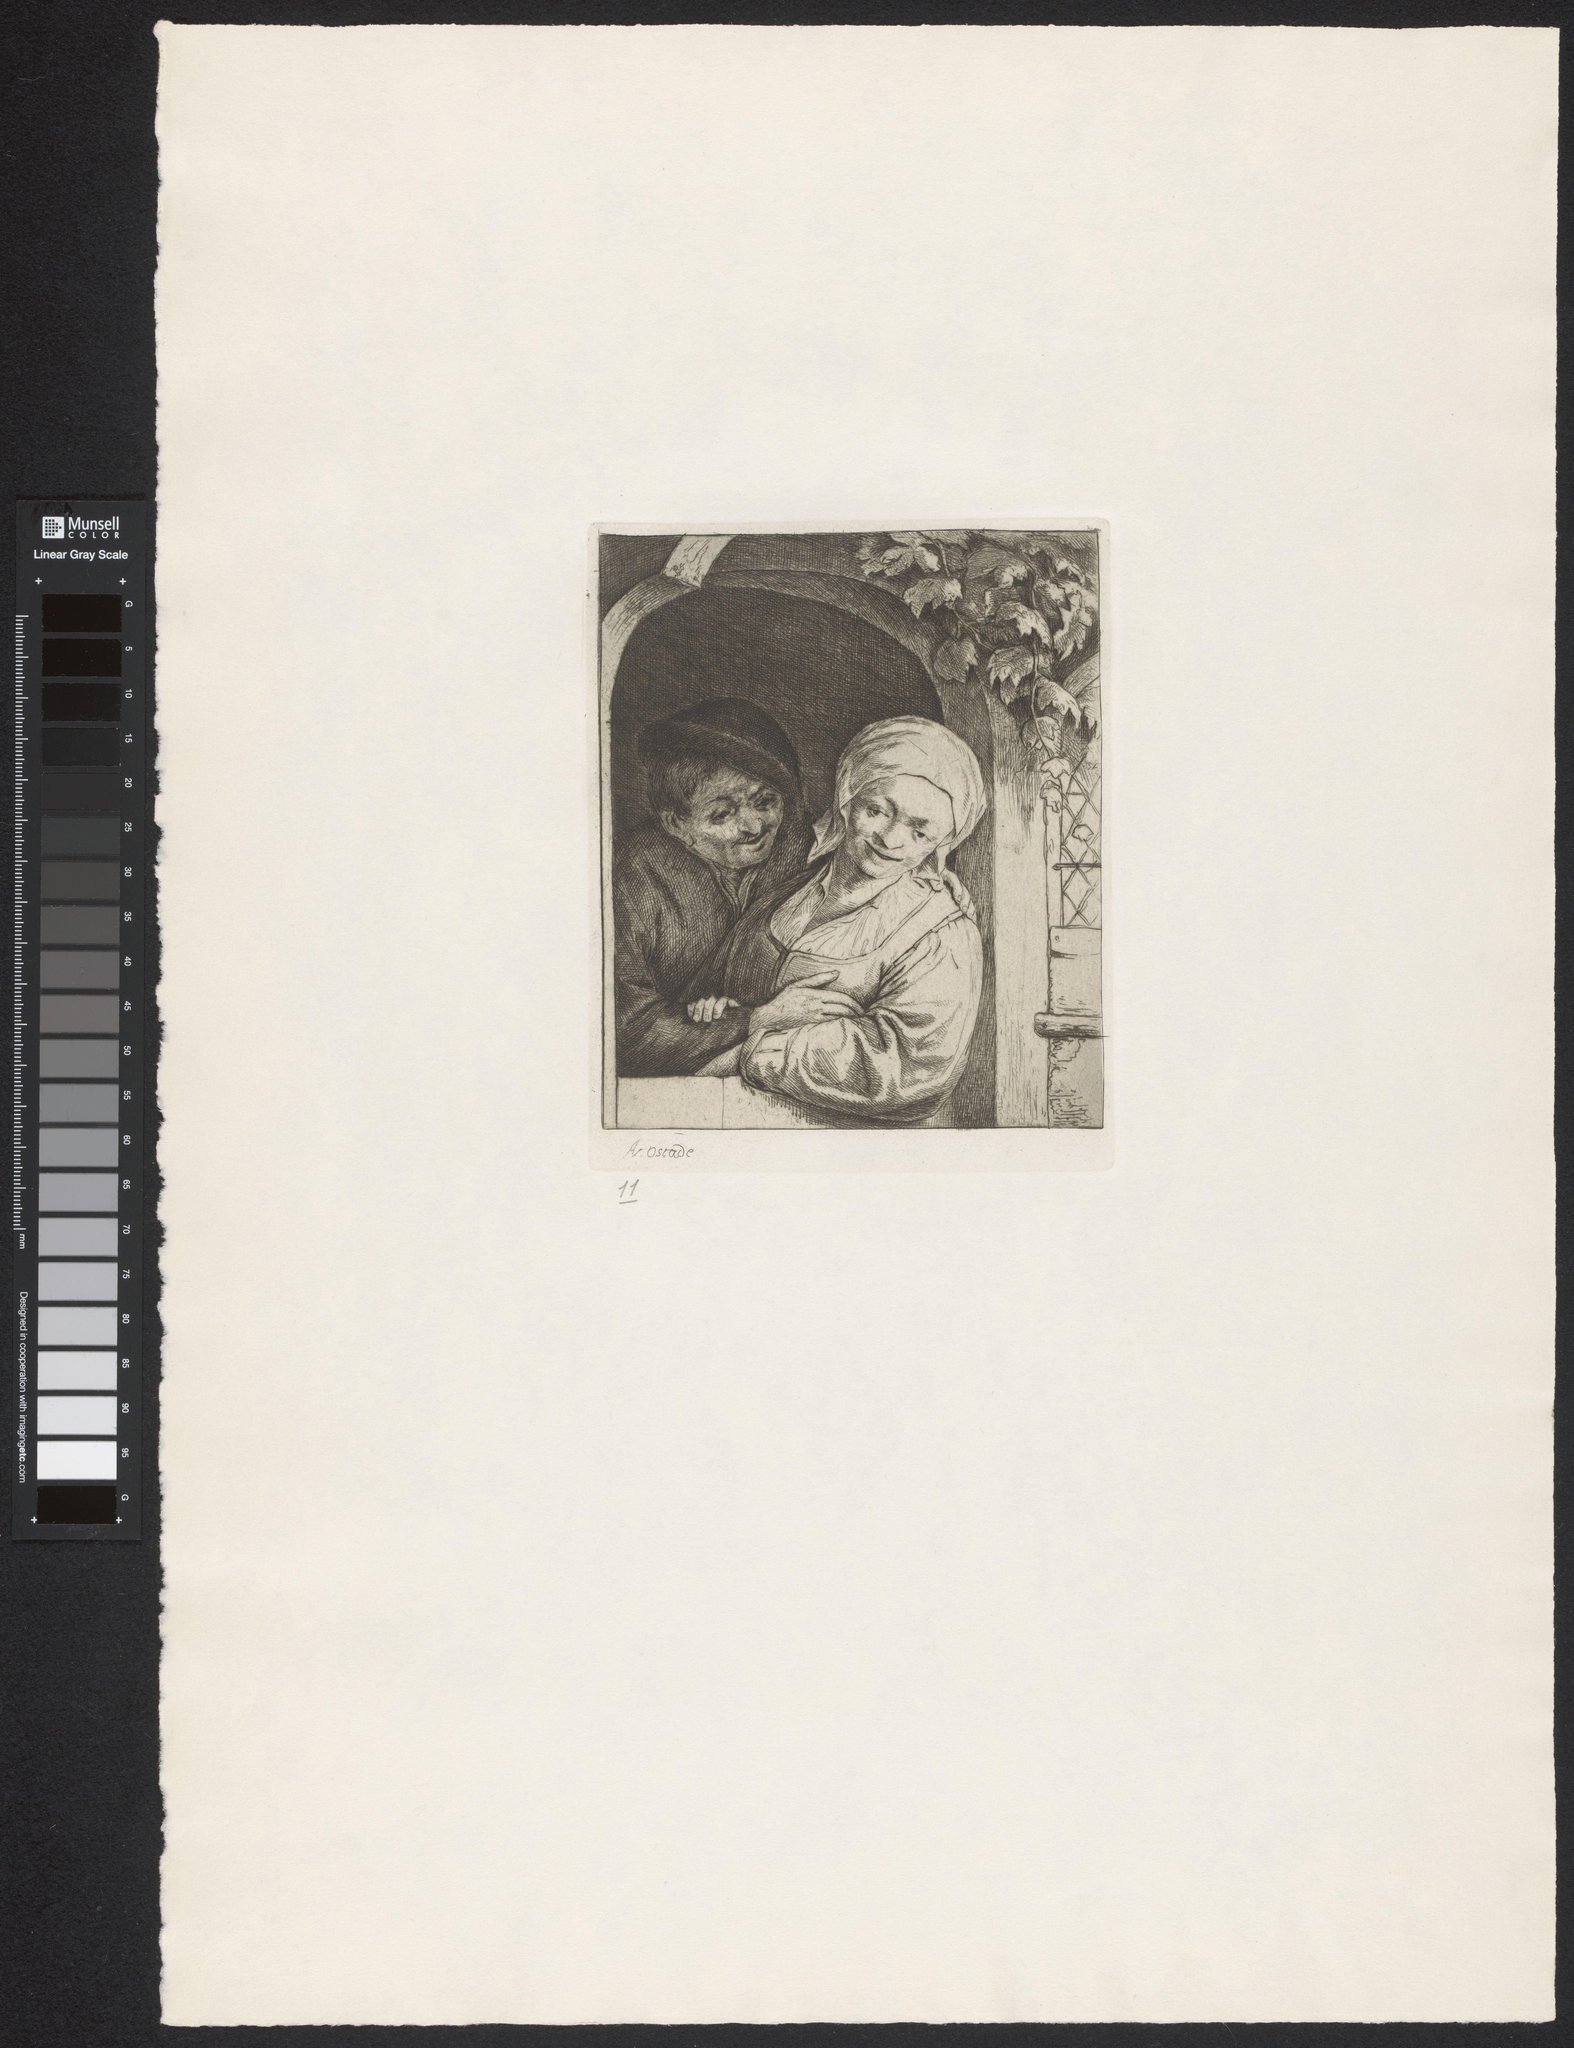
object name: print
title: Wandelend boerenpaar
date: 1646-1649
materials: paper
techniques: etching, galvanization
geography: haarlem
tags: female sex; woman, farmers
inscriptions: collector's mark: ‘RIJKS / MUSM’, collector's mark: ‘B’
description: De prent maakt deel uit van een portefeuille en is met een andere prent op één albumblad gedrukt.